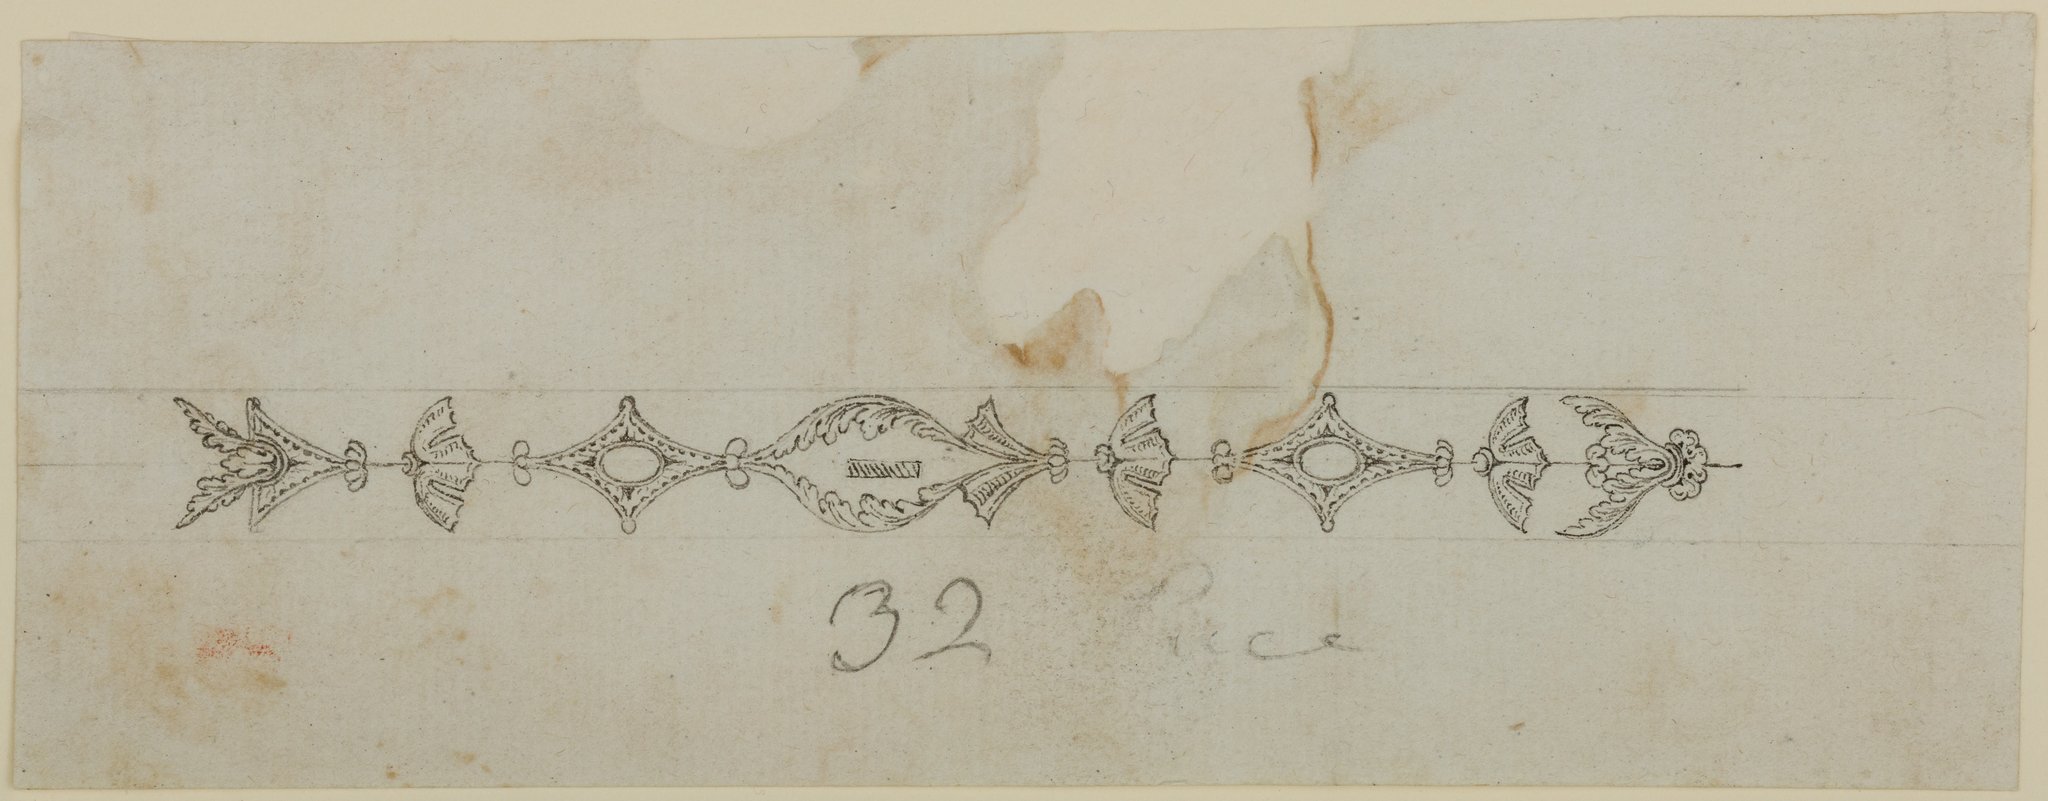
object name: drawing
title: Design for the Decoration of Firearms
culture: french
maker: nicolas noël boutet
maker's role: designer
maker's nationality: french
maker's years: 1761-1833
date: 1797-1805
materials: ink, paper, pencil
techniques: wash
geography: france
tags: ornament